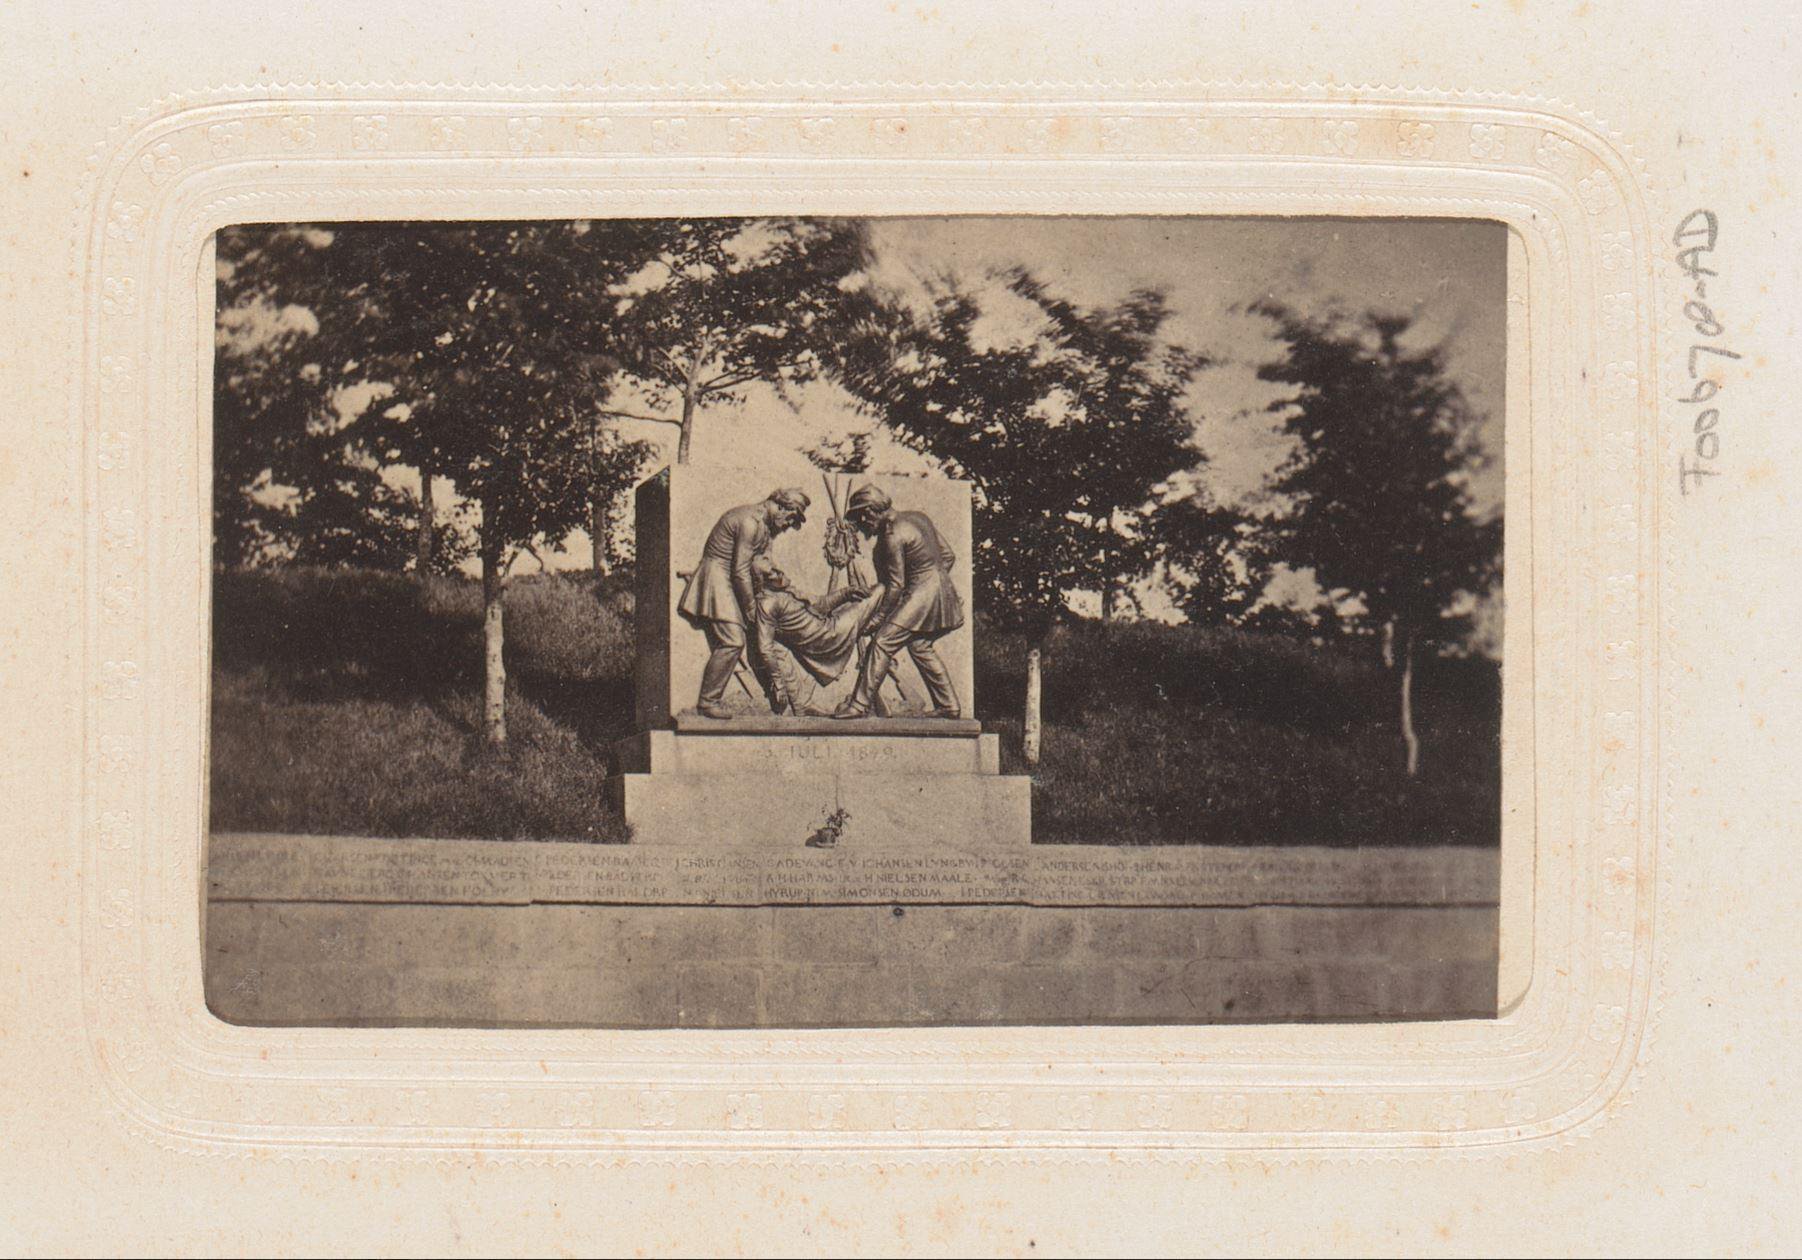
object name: photograph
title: Monument voor gevallen soldaten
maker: Anonymous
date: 1860-1880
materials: cardboard, photographic support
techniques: albumen print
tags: other memorial structures